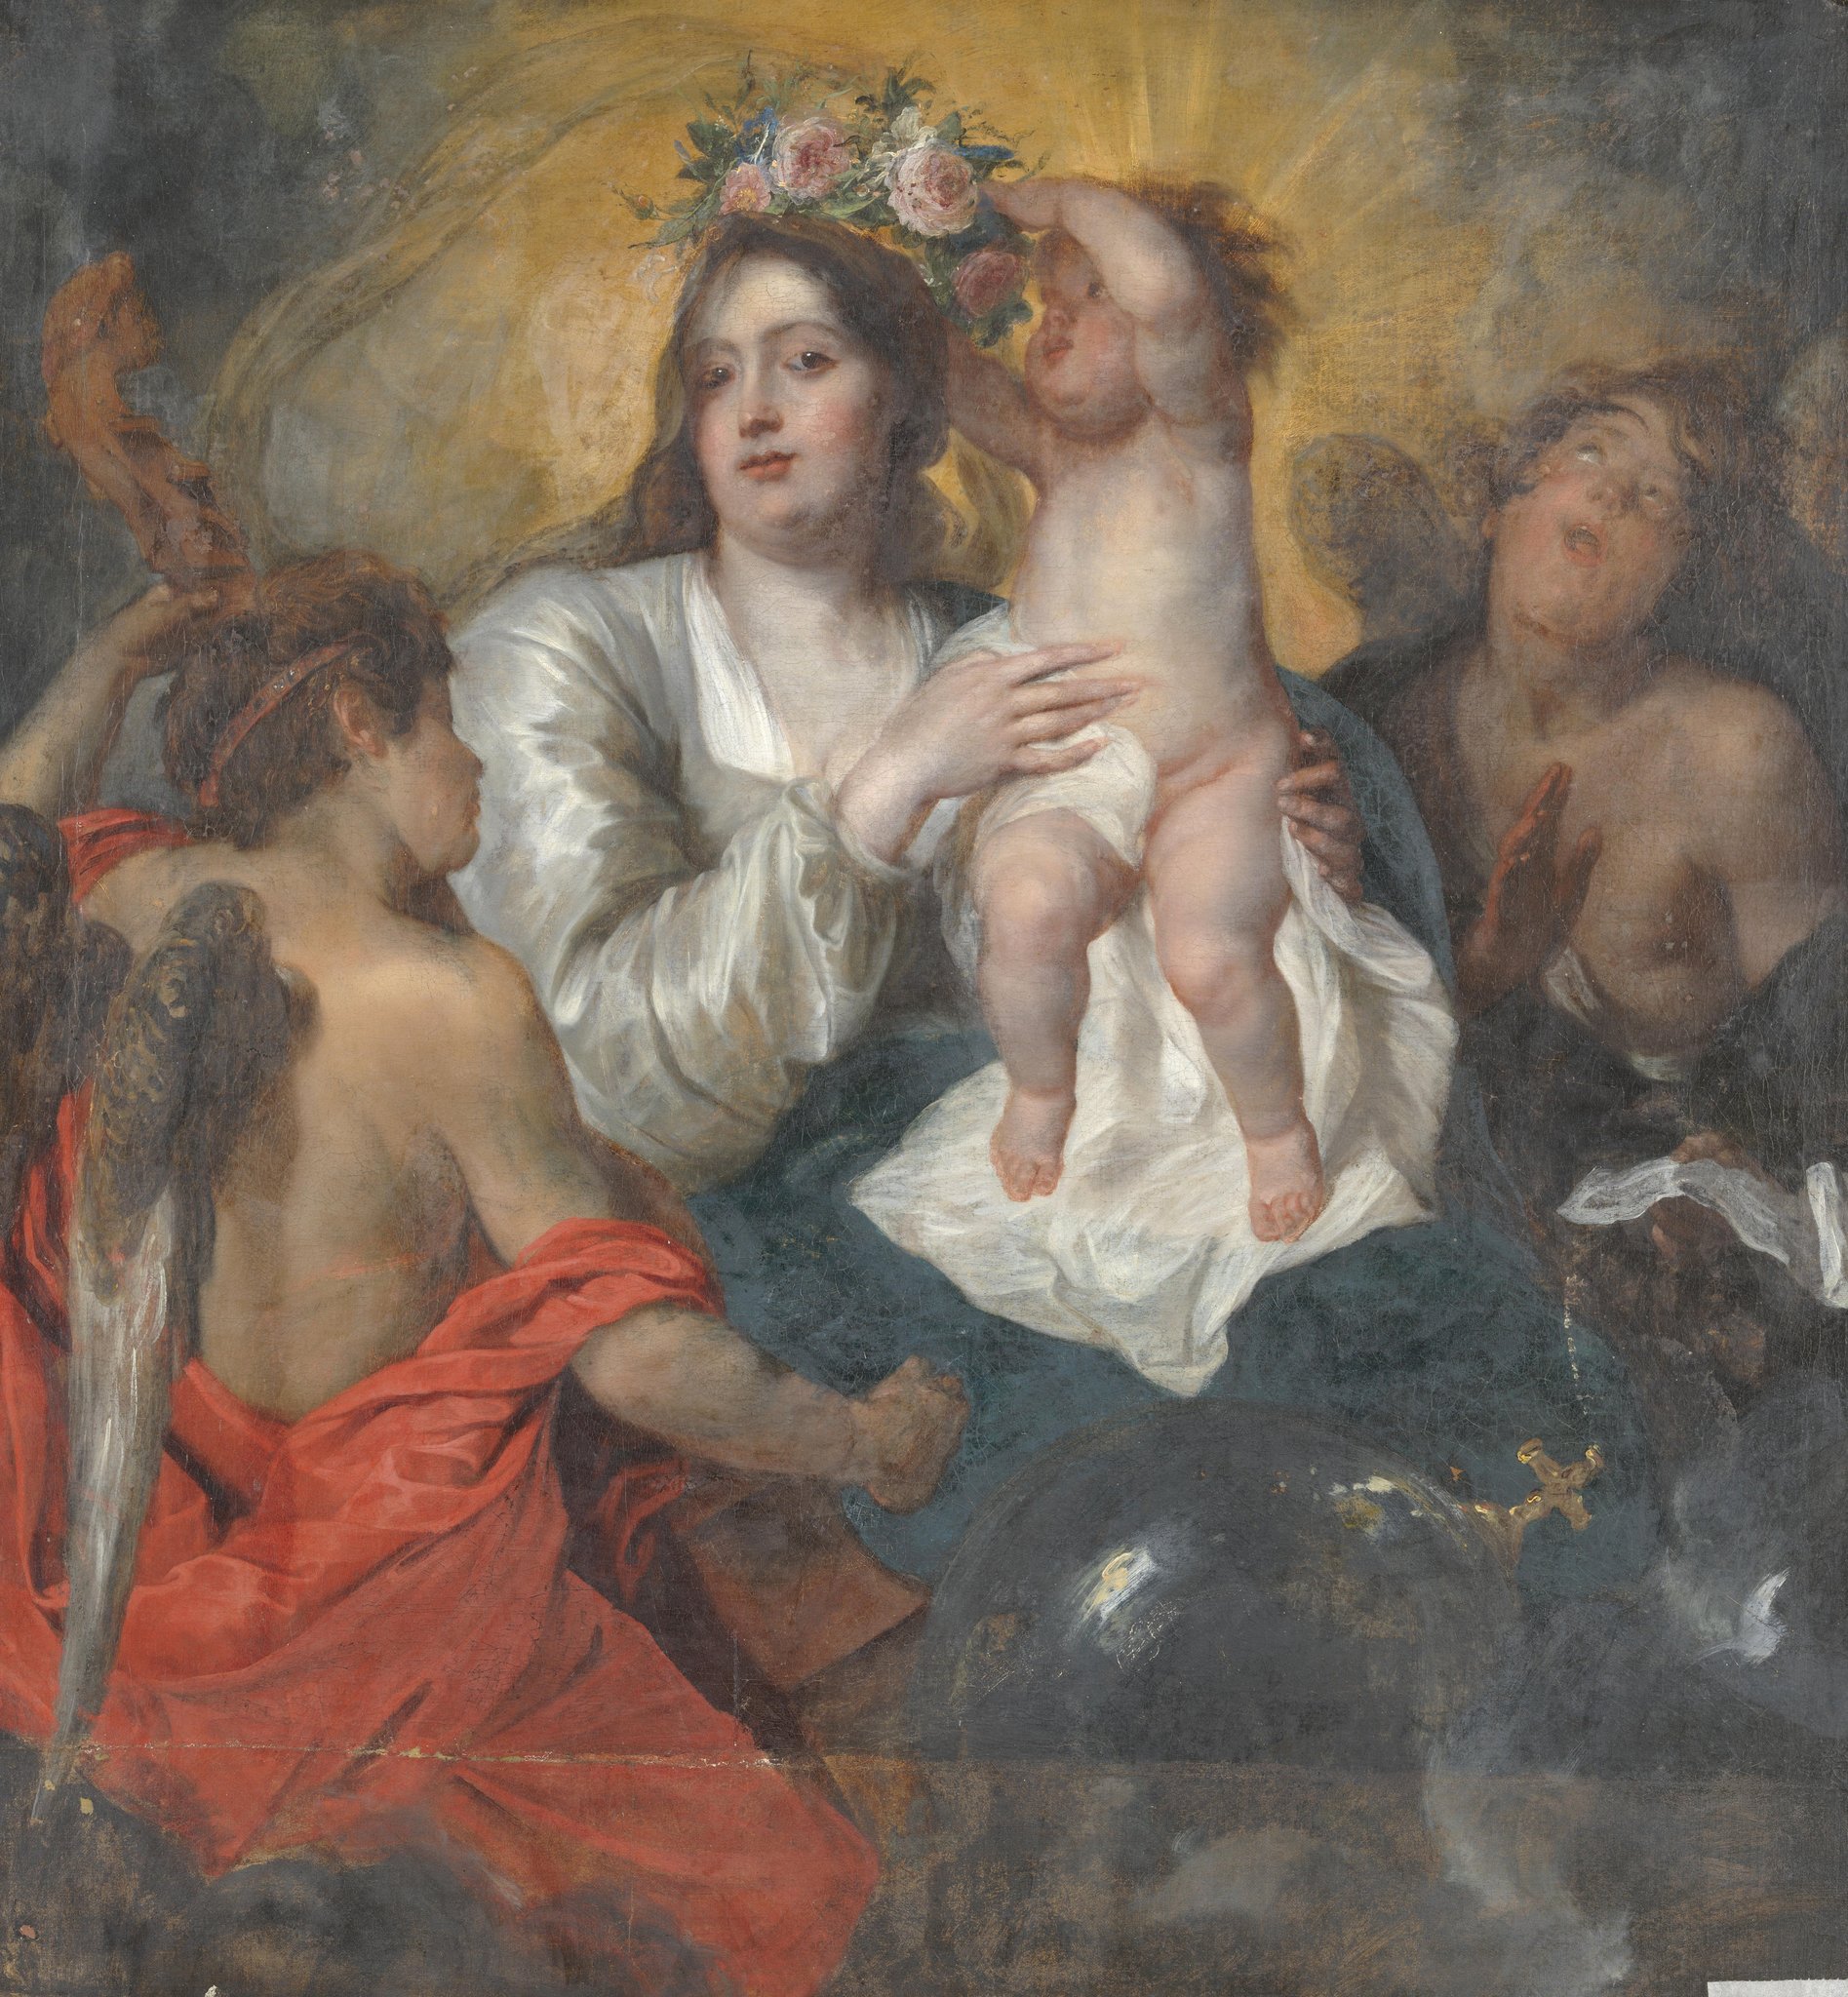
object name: painting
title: The Virgin Crowned by the Infant Christ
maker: thomas willeboirts bosschaert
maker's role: draughtsman, painter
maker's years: 1613-1654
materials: canvas, oil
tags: the christ-child crowning mary ~ madonna-representations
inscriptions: signature, on the rim of the viola da gamba: ‘Wilebors’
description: Thomas Willeboirts Bosschaert (1614 - 1654). The apotheosis of the Virgin, c. 1640. The Virgin Mary is being crowned by the Christ Child with a garland of flowers. Angels sing and make music as they take par t in this tribute. Willeboirts Bosschaert has portrayed the scene in warm tones and with a lively brush. The artist was a pupil of Gerard Seghers; he worked in the ateliers of Rubens en Van Dyck and was one of the artists involved in the decoration of the Oranjezaal. Frederik Hendrik and Amalia van Solms owned dozens of such history pieces by Bosschaert.